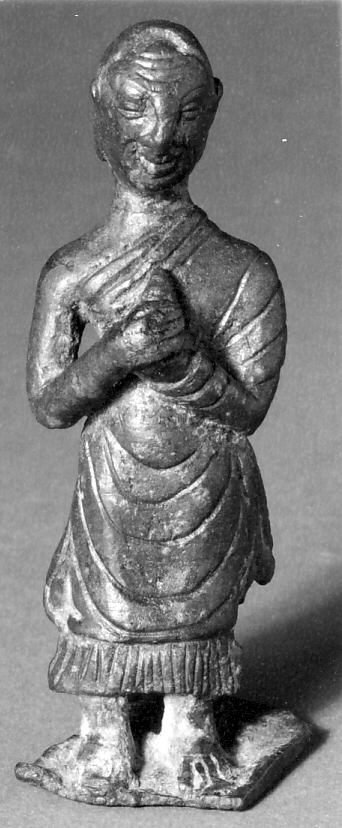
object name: figure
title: Standing Monk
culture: gandhara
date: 201-300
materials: bronze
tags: gandhara,monks